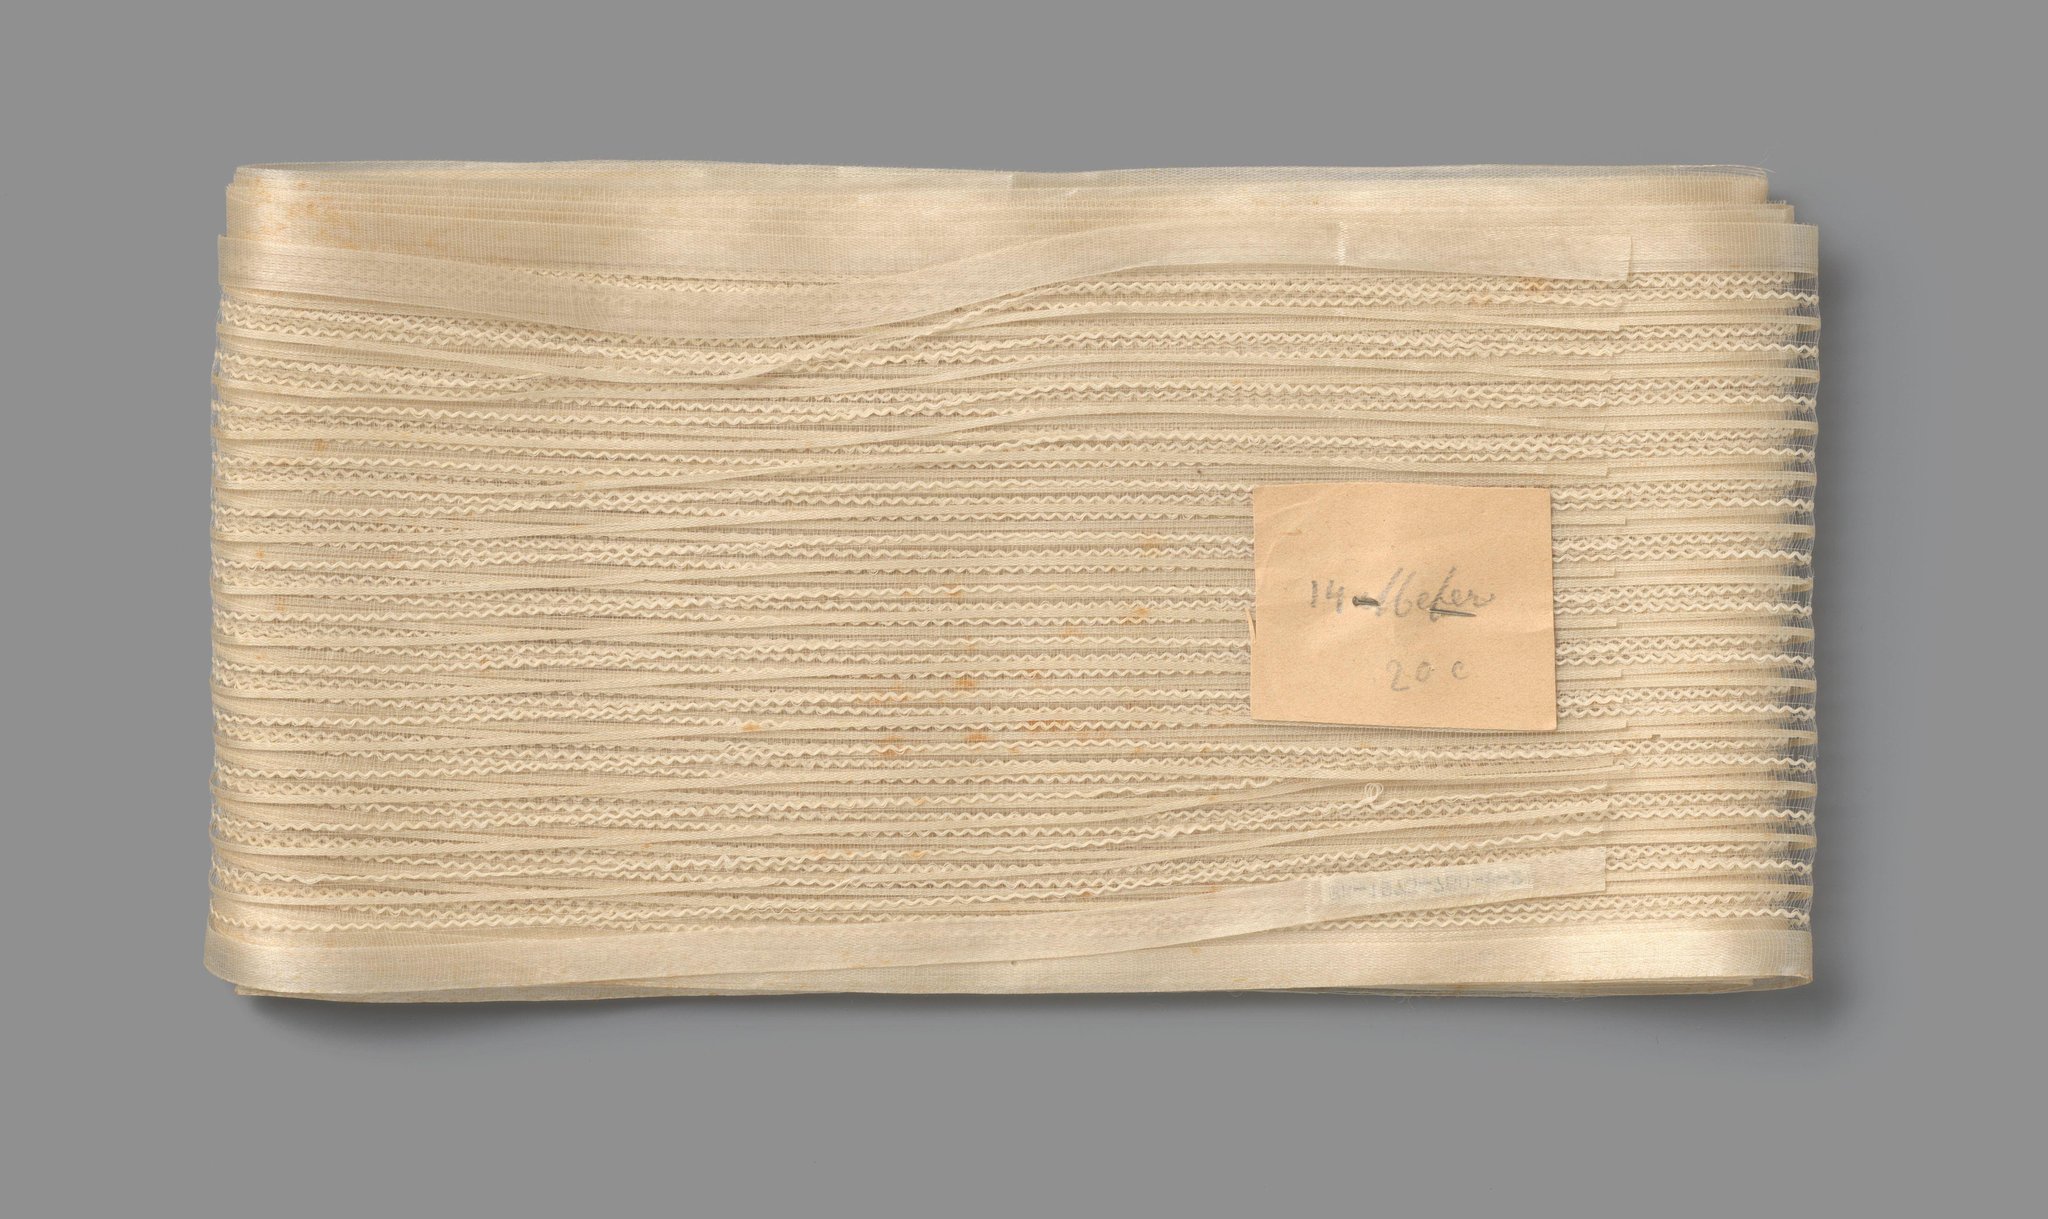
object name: braid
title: Metrage crème-wit lint van zijden gaas met ingeweven zigzagpatroon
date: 1900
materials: silk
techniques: weave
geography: nijmegen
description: Metrage crème-wit lint van zijden gaas met ingeweven zigzagpatroon.